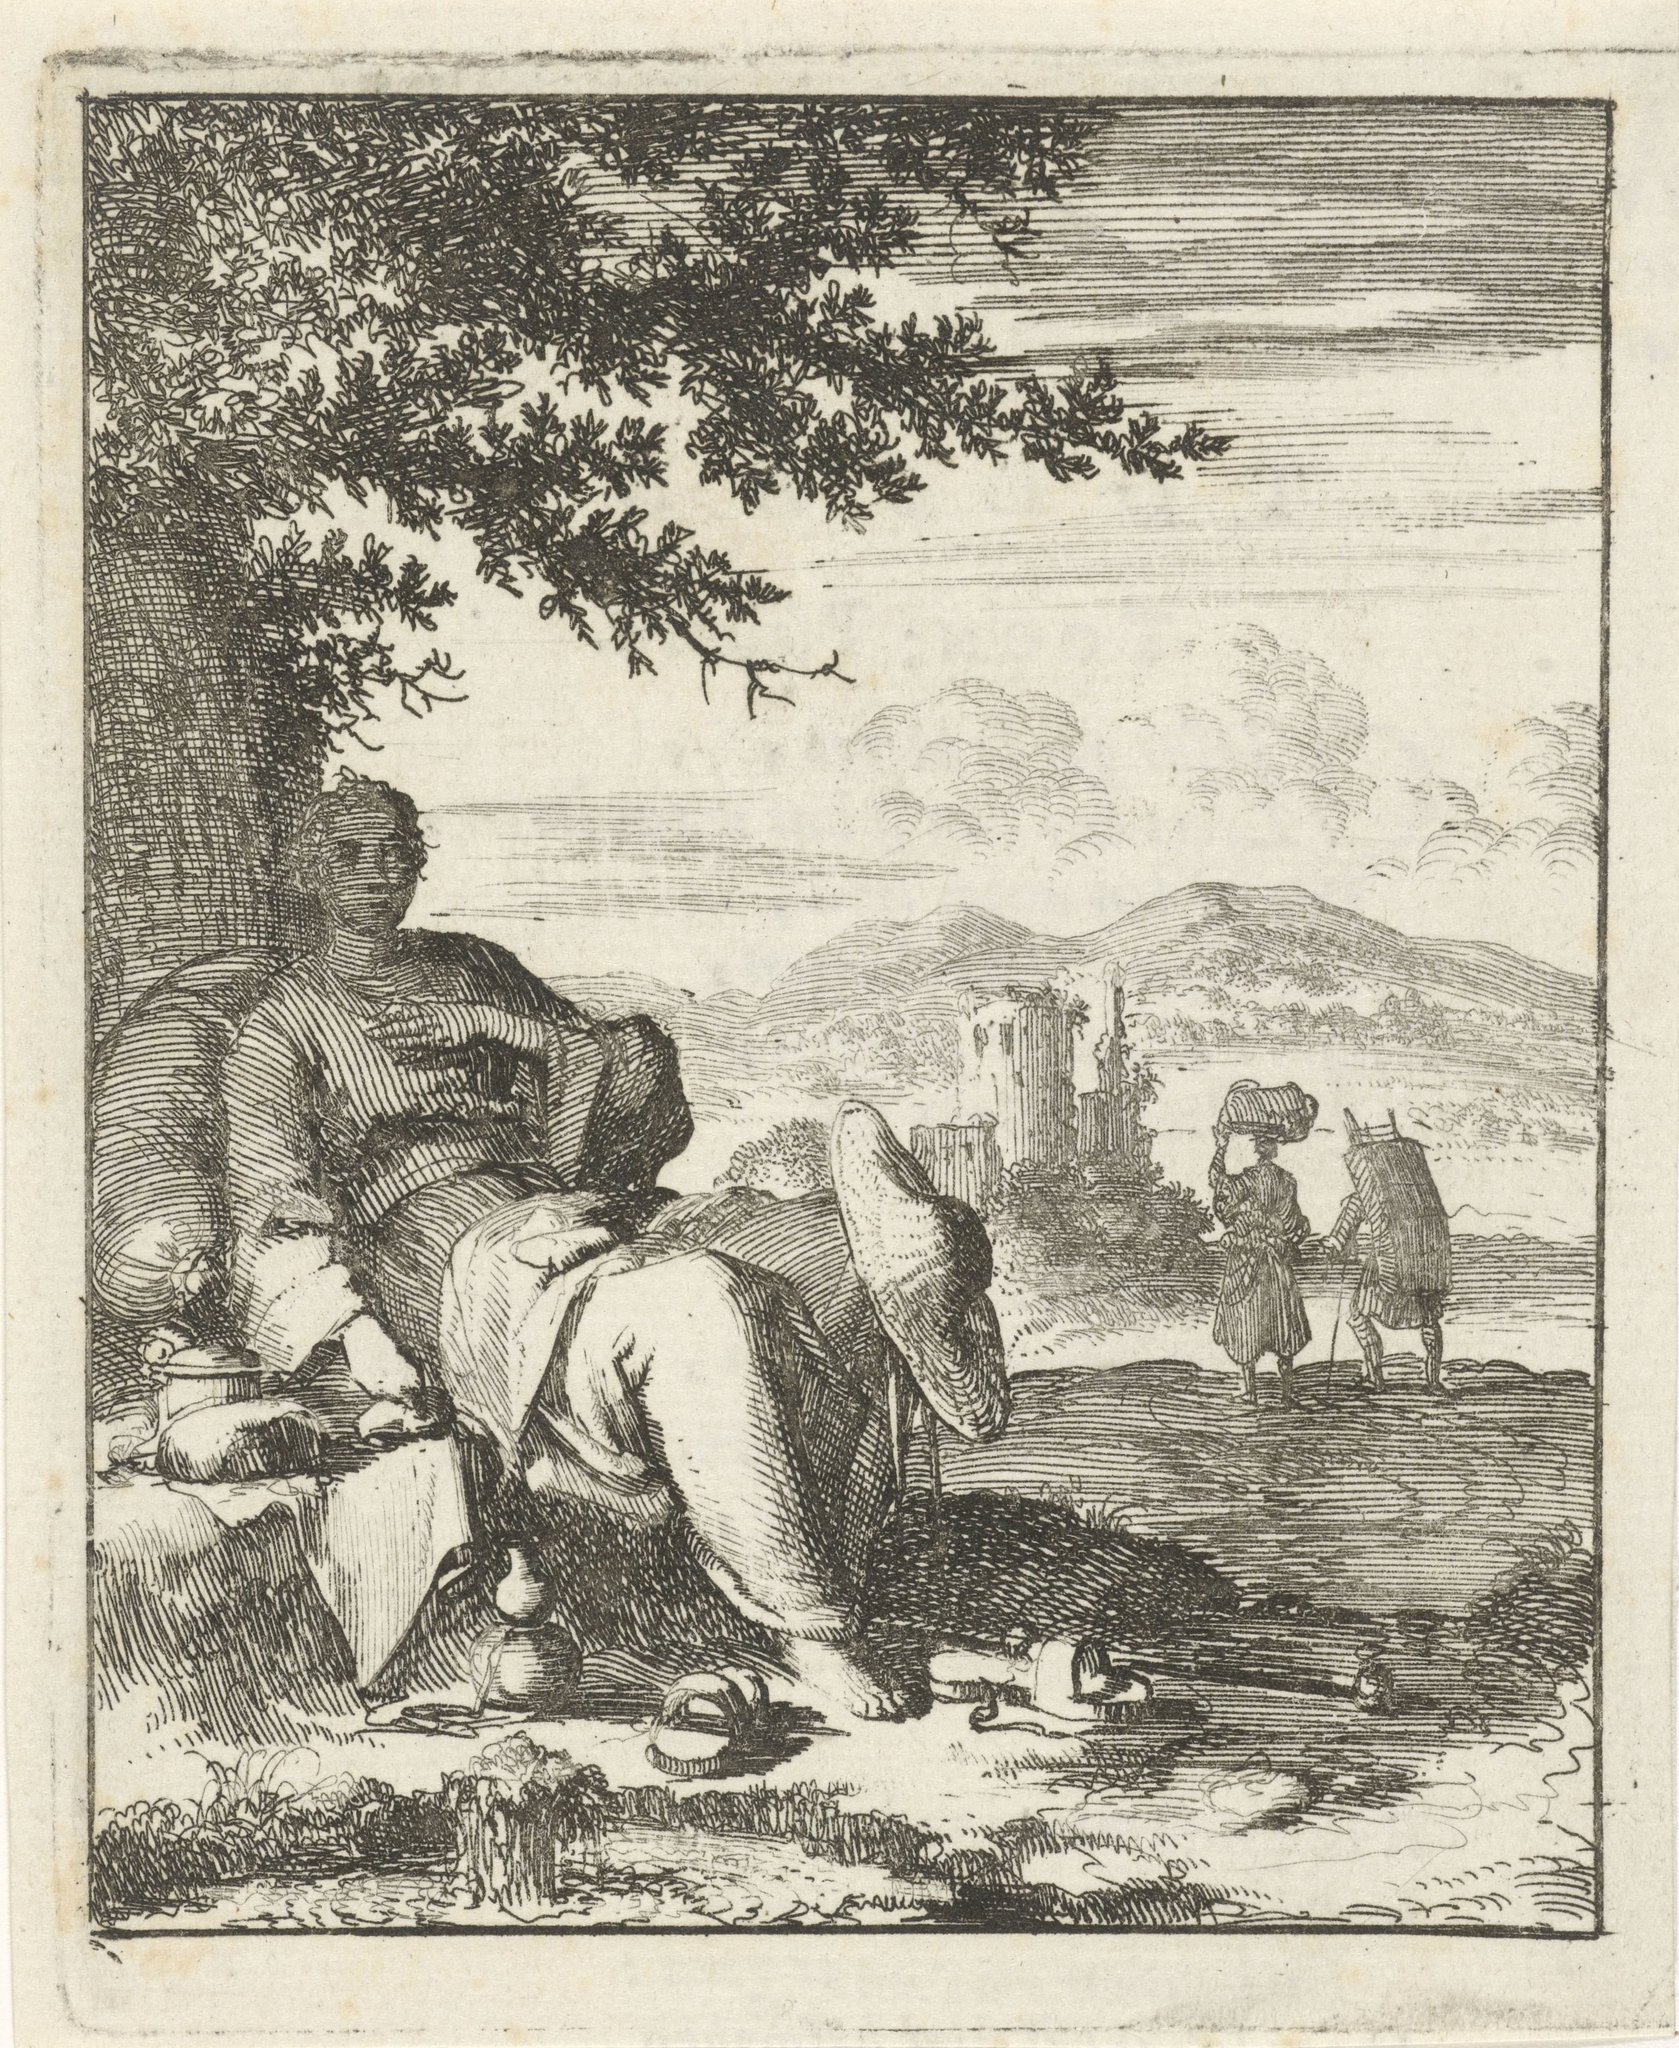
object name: book illustration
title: Vrouw zittend in de schaduw onder een boom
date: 1687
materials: paper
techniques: etching, letterpress printing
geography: amsterdam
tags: shadow of an object, trees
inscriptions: collector's mark: Lugt 2228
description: Illustratie uit: Luyken, Jan. Voncken der liefde Jesu, van het godtbegerende zielenvier. Amsterdam: Pieter Arentsz (II), 1687, p. 160.